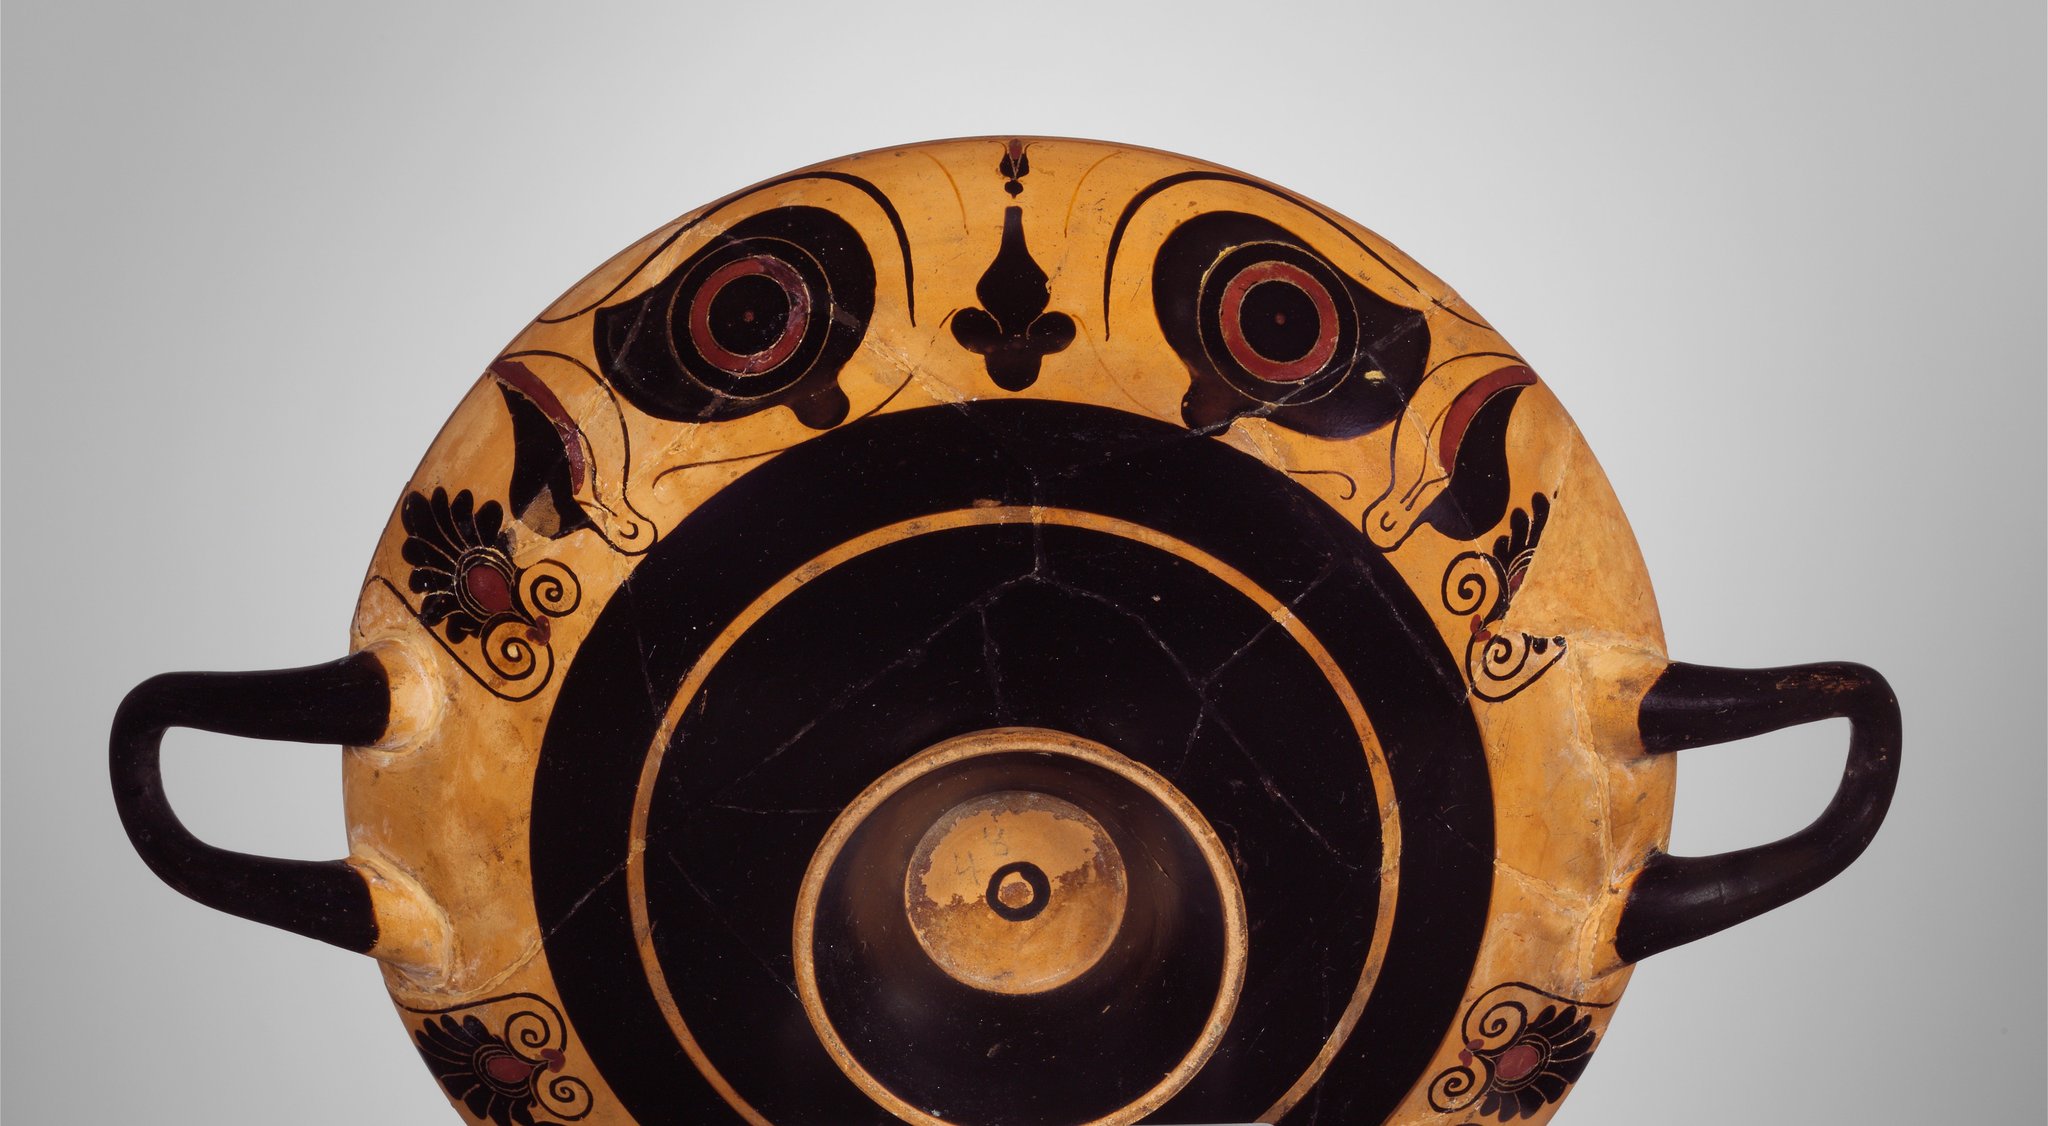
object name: kylix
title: Terracotta kylix (drinking cup)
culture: greek, chalcidian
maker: group of the phineus painter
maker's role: artist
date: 540-520 BCE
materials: terracotta